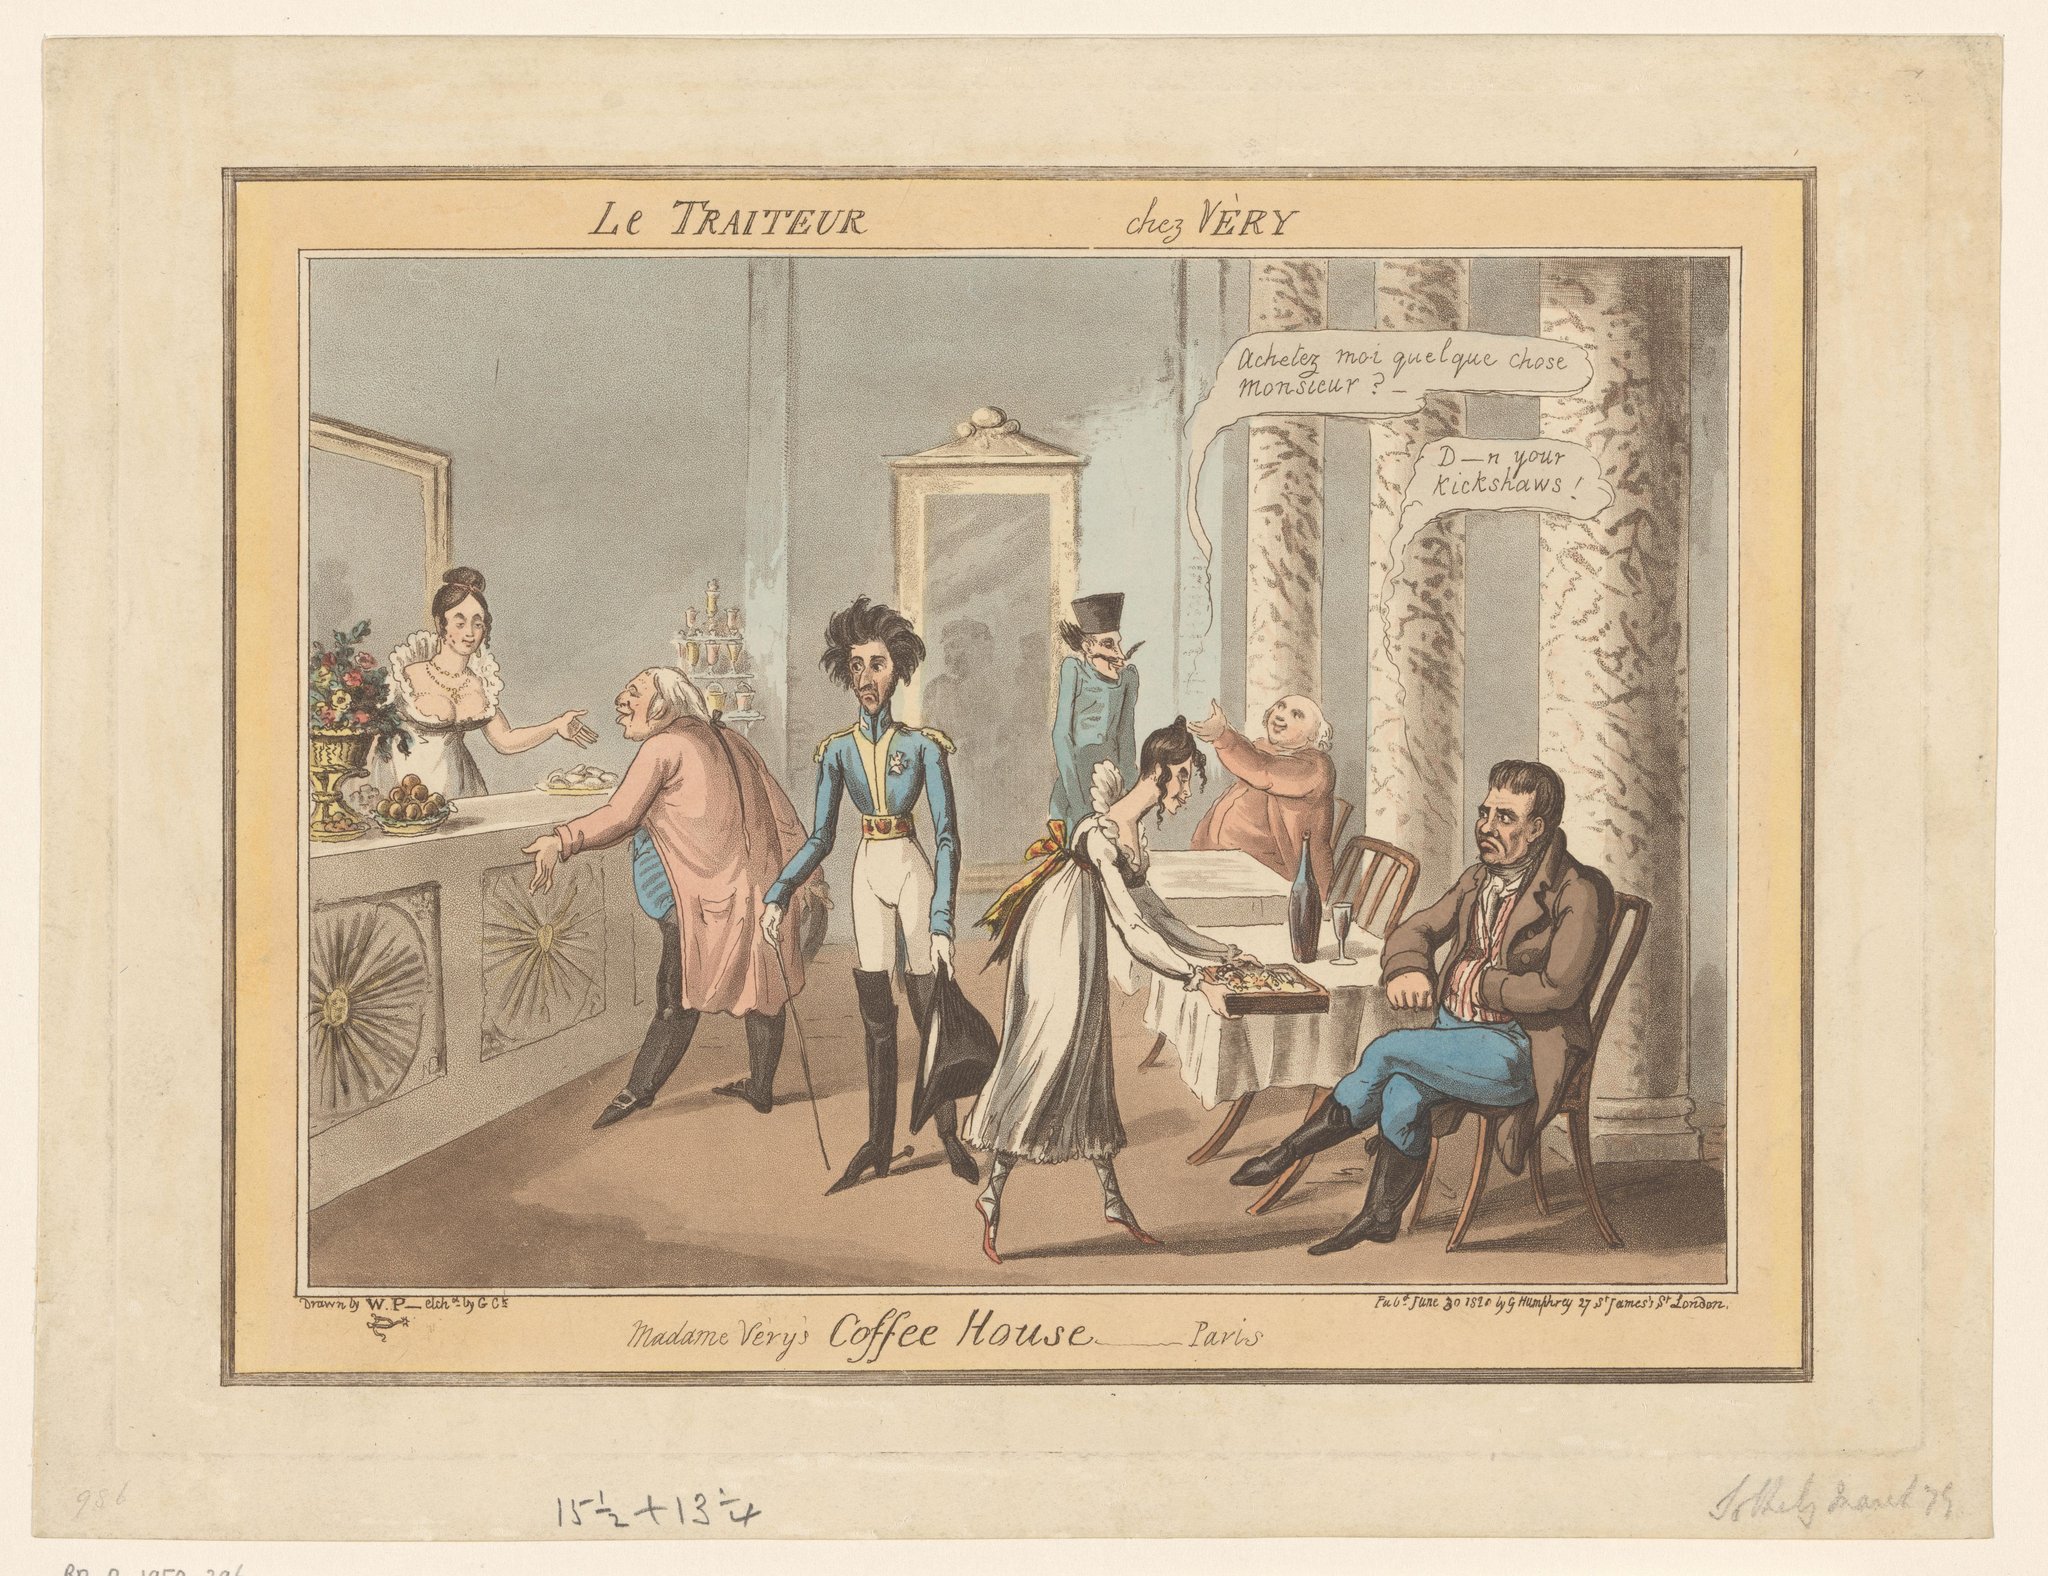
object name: print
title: John Bull zit in het koffiehuis van mevrouw Véry te Parijs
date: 1806-1821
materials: paper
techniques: aquatint, etching, hand coloring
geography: london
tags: personifications of countries, nations, states, districts, etc., inn, coffee-house, public house, etc., paris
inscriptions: collector's mark: Lugt 2228